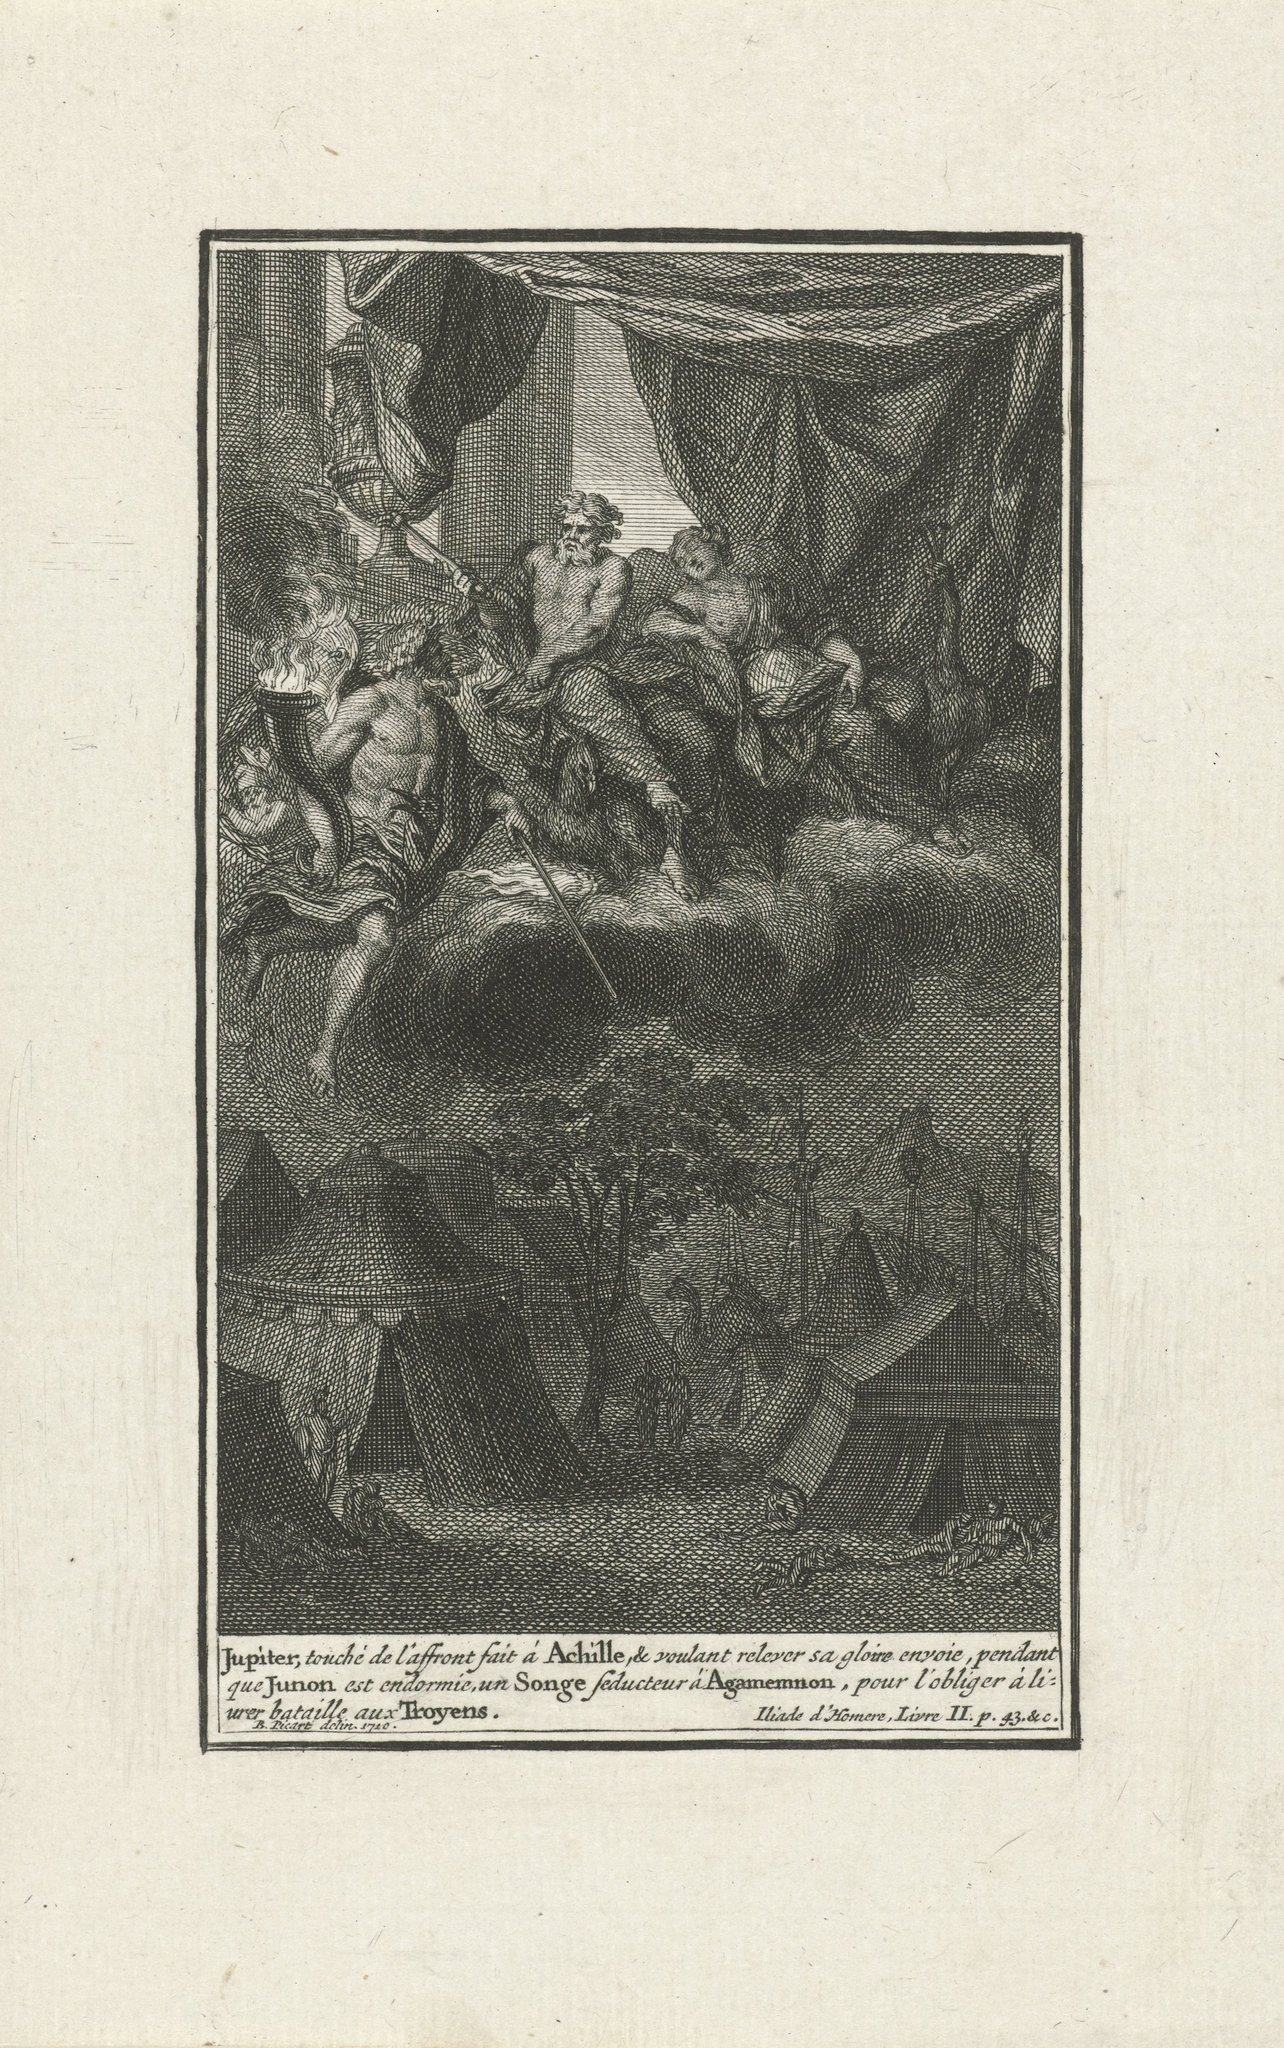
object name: book illustration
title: De droom van Agamemnon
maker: bernard picart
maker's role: draughtsman, print maker, publisher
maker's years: 1673-1733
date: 1710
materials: paper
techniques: engraving, etching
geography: amsterdam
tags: the dream of agamemnon: morpheus, in the shape of nestor, urges him to attack (+ variant)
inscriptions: collector's mark: Lugt 240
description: Jupiter verleidt Agamemnon, de bevelhebber van de Griekse troepen, in een droom om de strijd weer aan te gaan met de Trojanen. In de marge een onderschrift in het Frans.